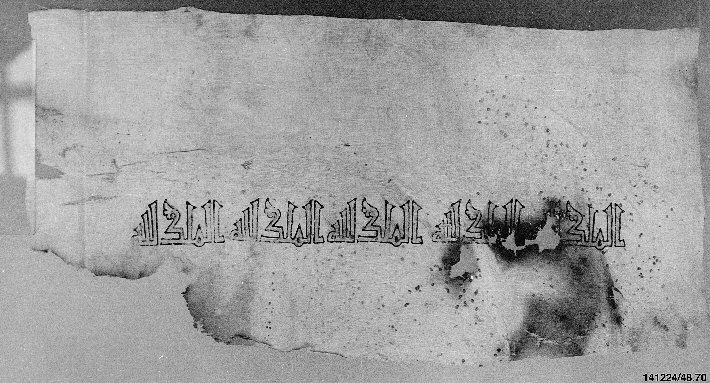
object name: textile fragment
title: Tiraz Fragment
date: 901-1000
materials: gold leaf, ink, linen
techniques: weave, printing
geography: egypt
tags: arabic